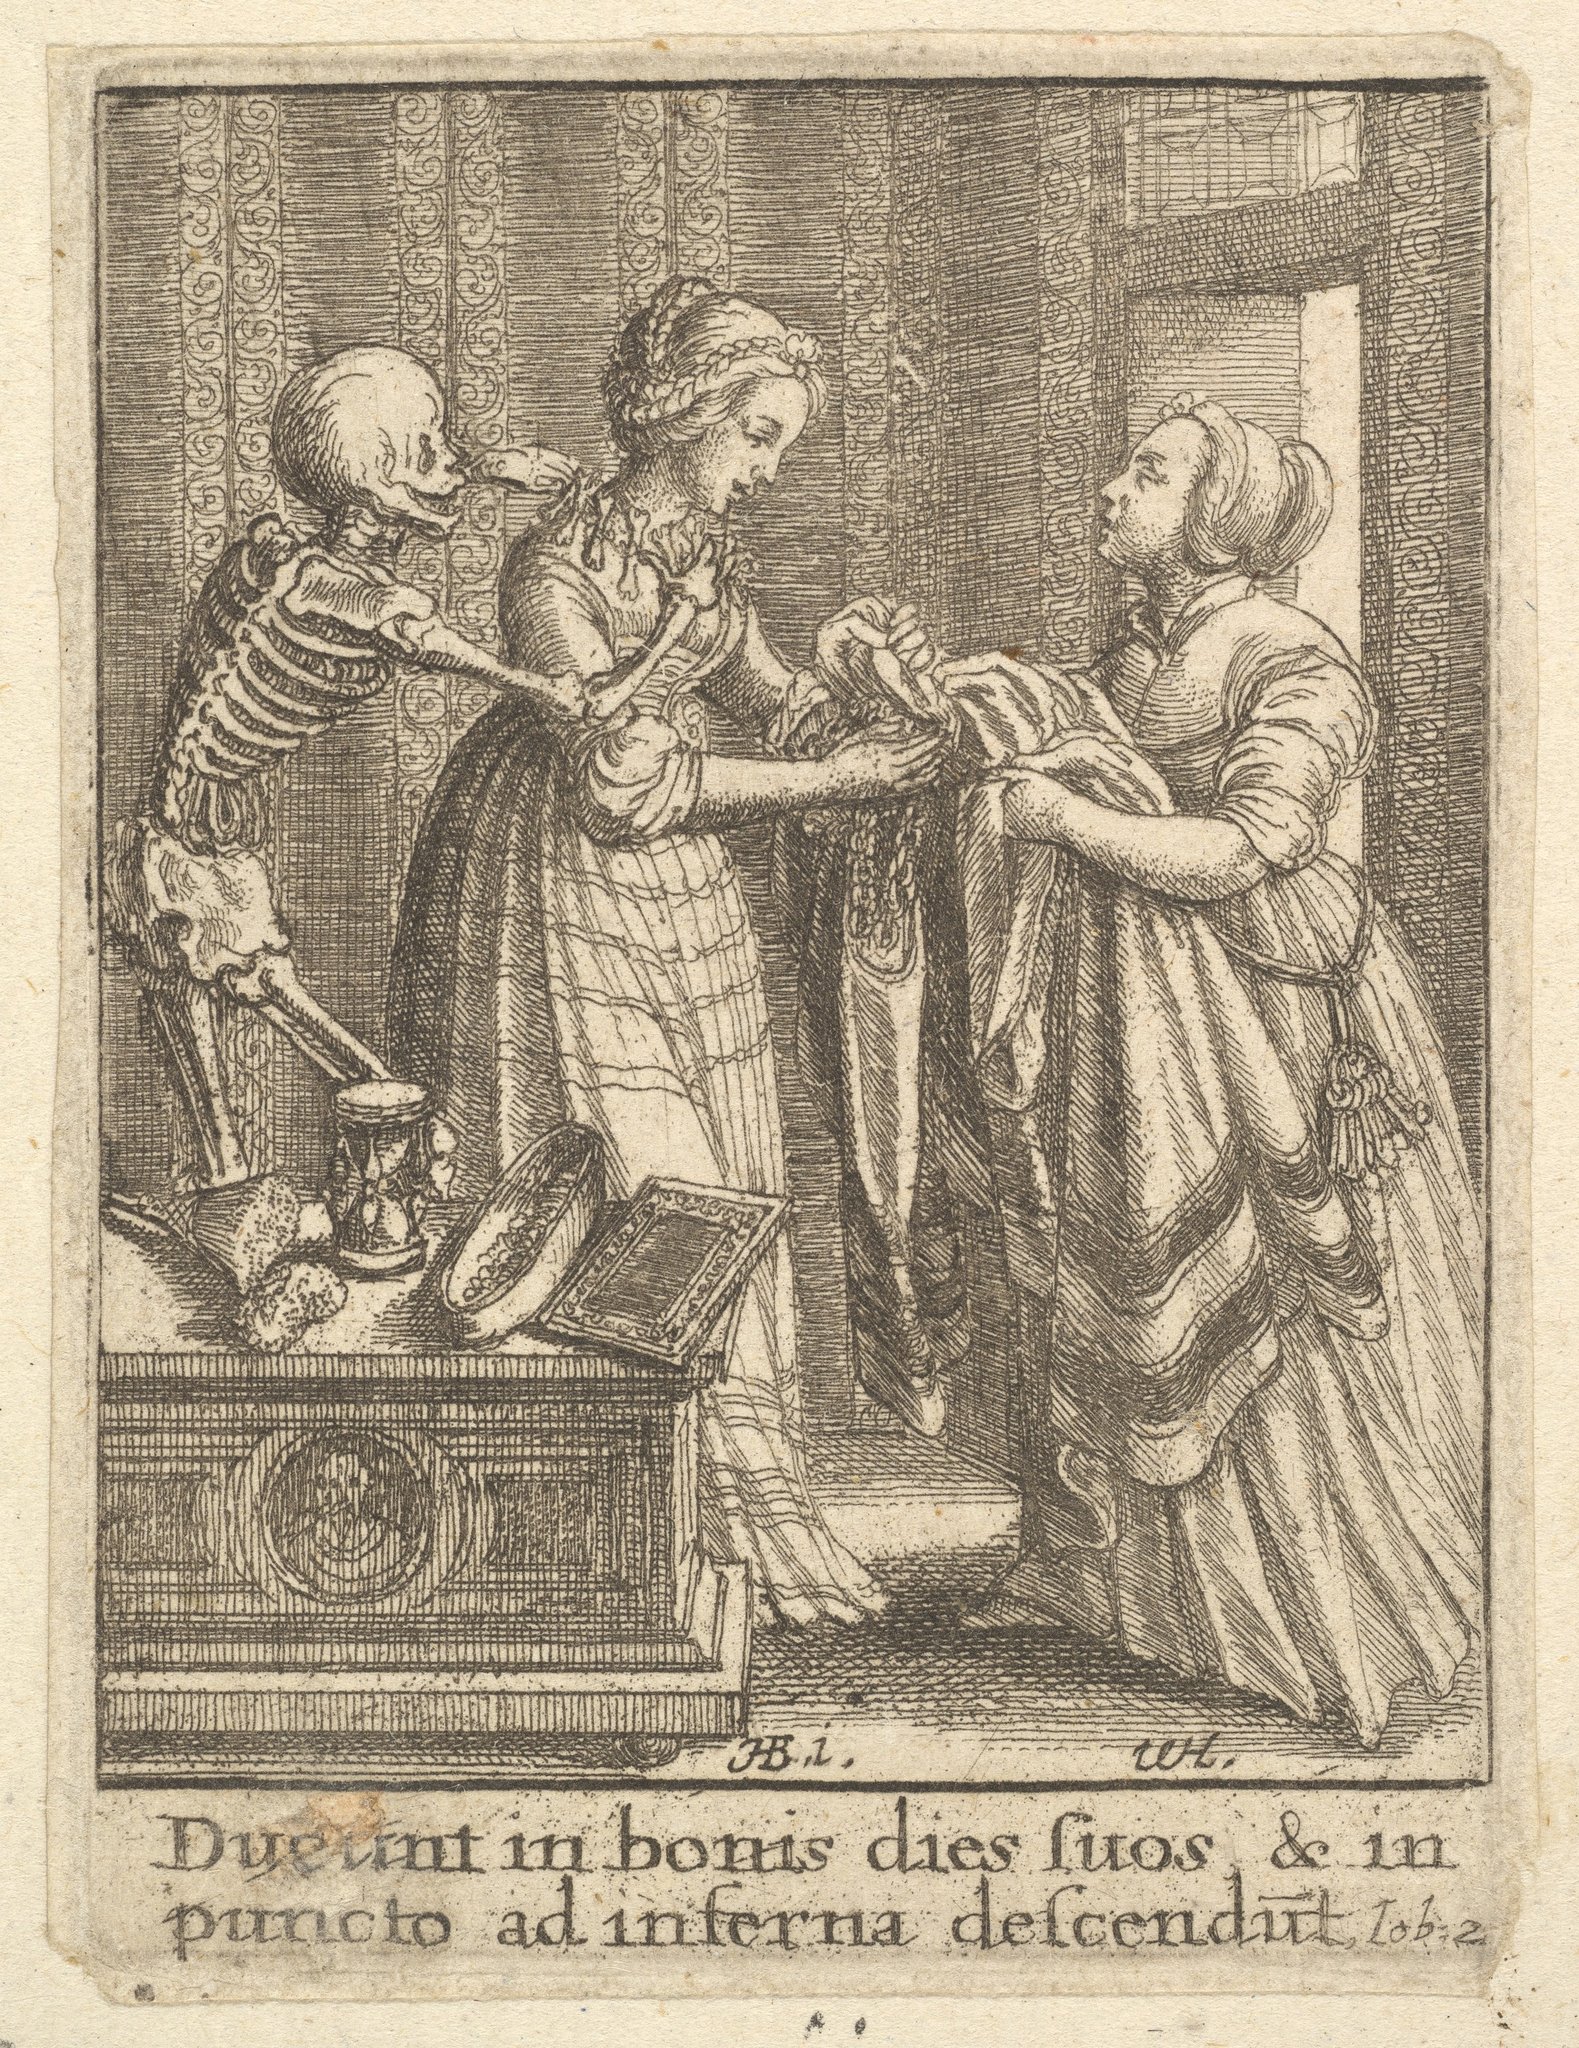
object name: print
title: Bride, from the Dance of Death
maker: wenceslaus hollar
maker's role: artist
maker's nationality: bohemian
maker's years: 1607-1677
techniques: etching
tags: skeletons,women